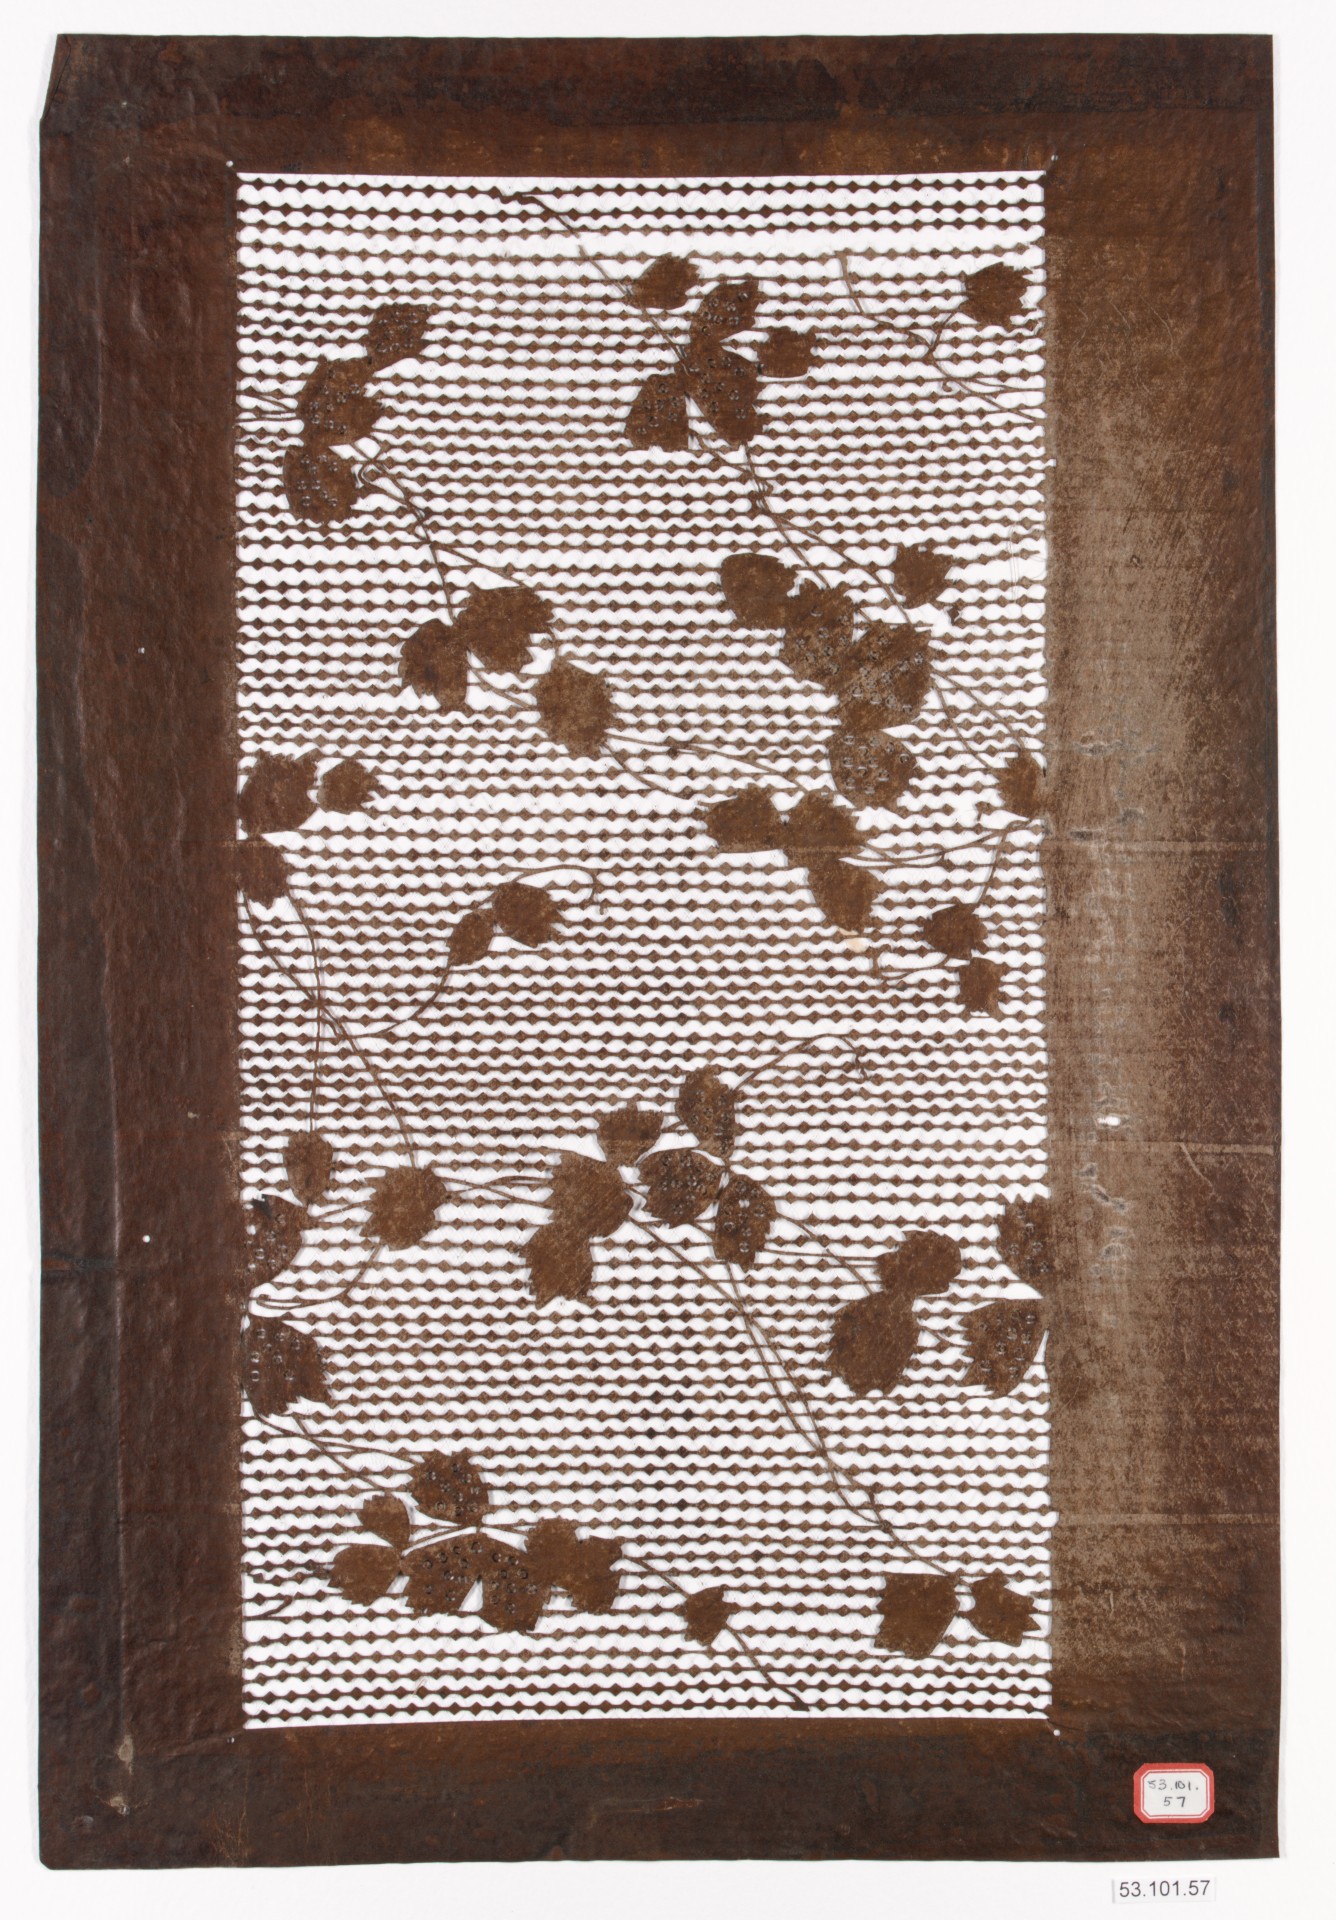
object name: stencil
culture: japanese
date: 1615-1868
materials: paper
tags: leaves